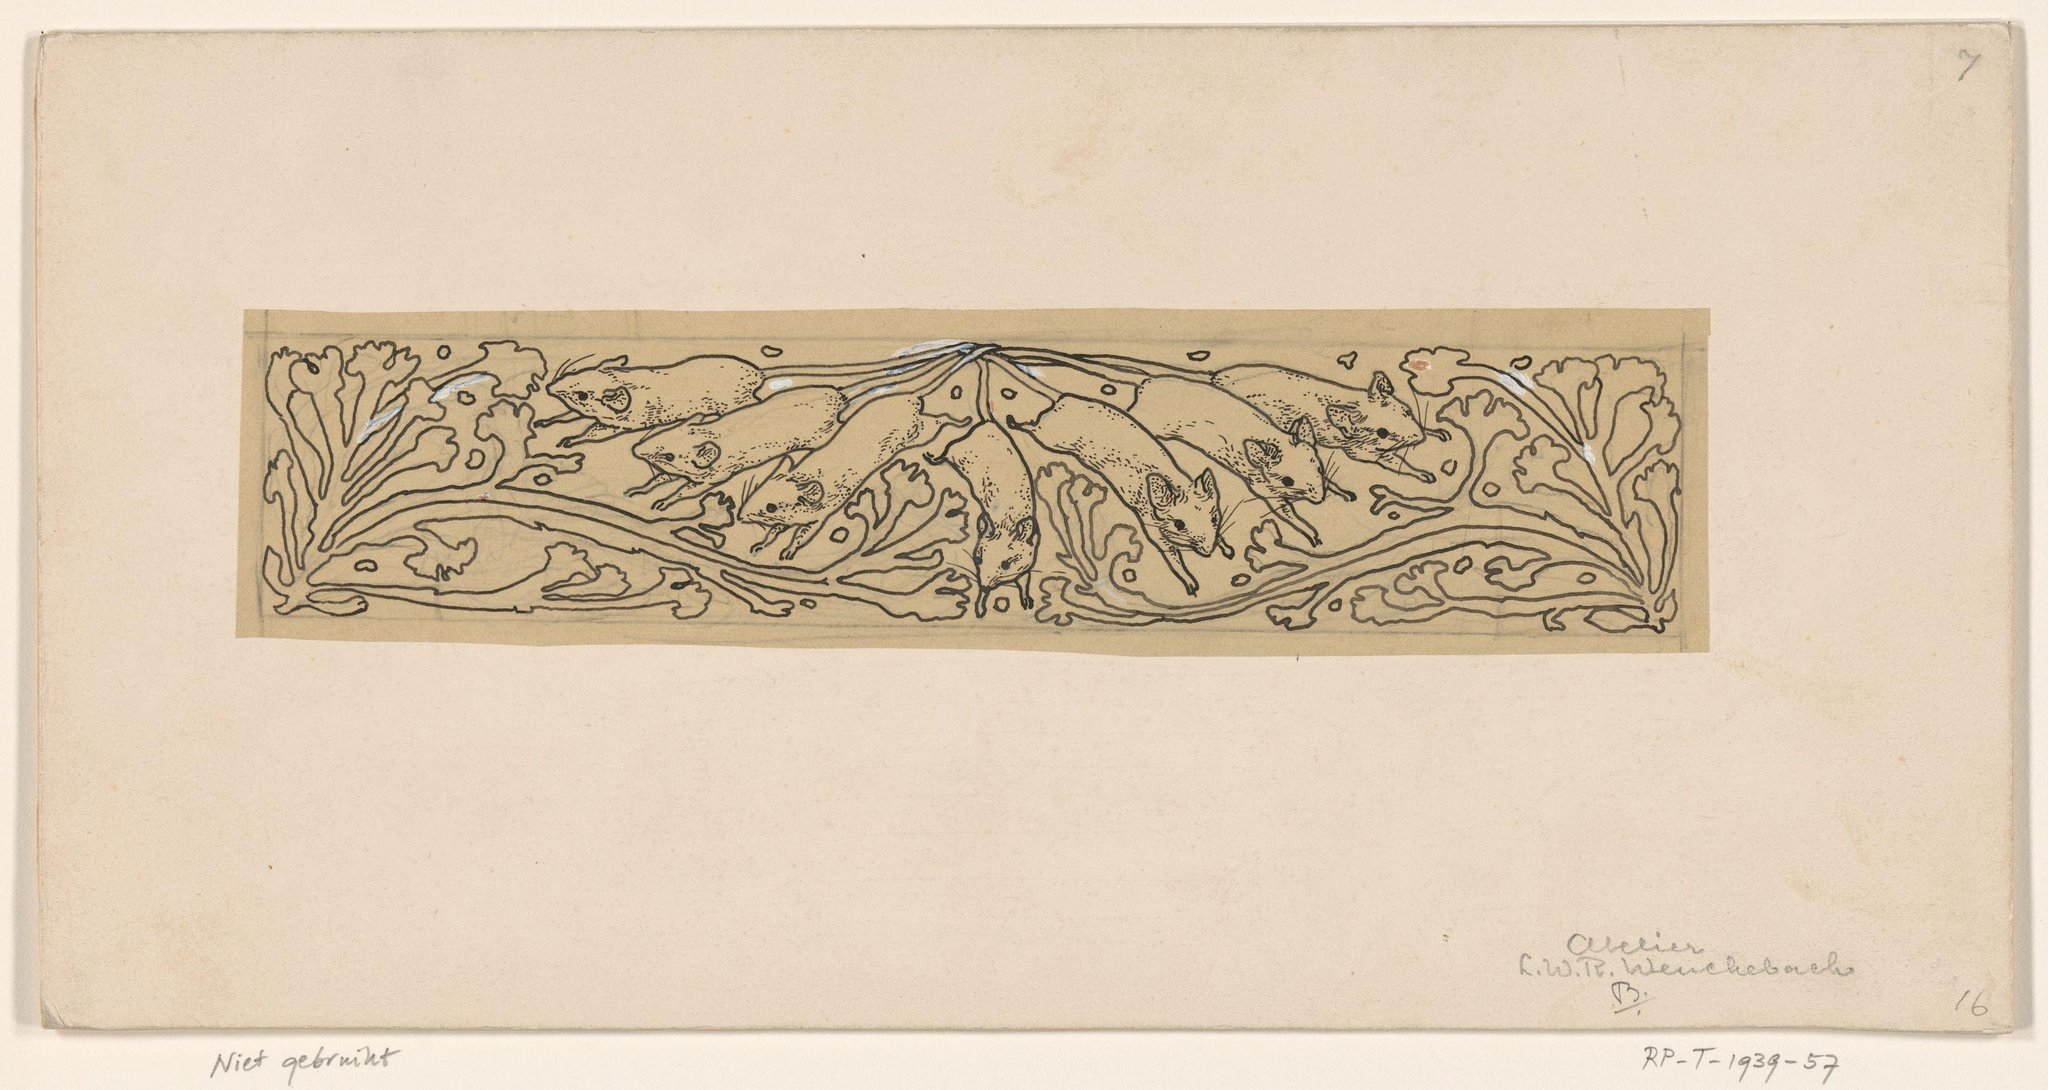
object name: drawing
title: Zeven met de staarten verbonden muizen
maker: willem wenckebach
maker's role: designer, draughtsman, painter, print maker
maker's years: 1860-1937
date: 1898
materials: cardboard, paint, ink, pencil, paper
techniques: brush, pen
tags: rodents: mouse, foliage, tendrils, branches ~ ornament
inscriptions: collector's mark: Lugt 2228a, number: ‘16’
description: Ontwerp voor: Hoffman, Ernst Theodor Amadeus. Notenkraker en muizenkoning. Amsterdam: Scheltema & Holkema, 1898.